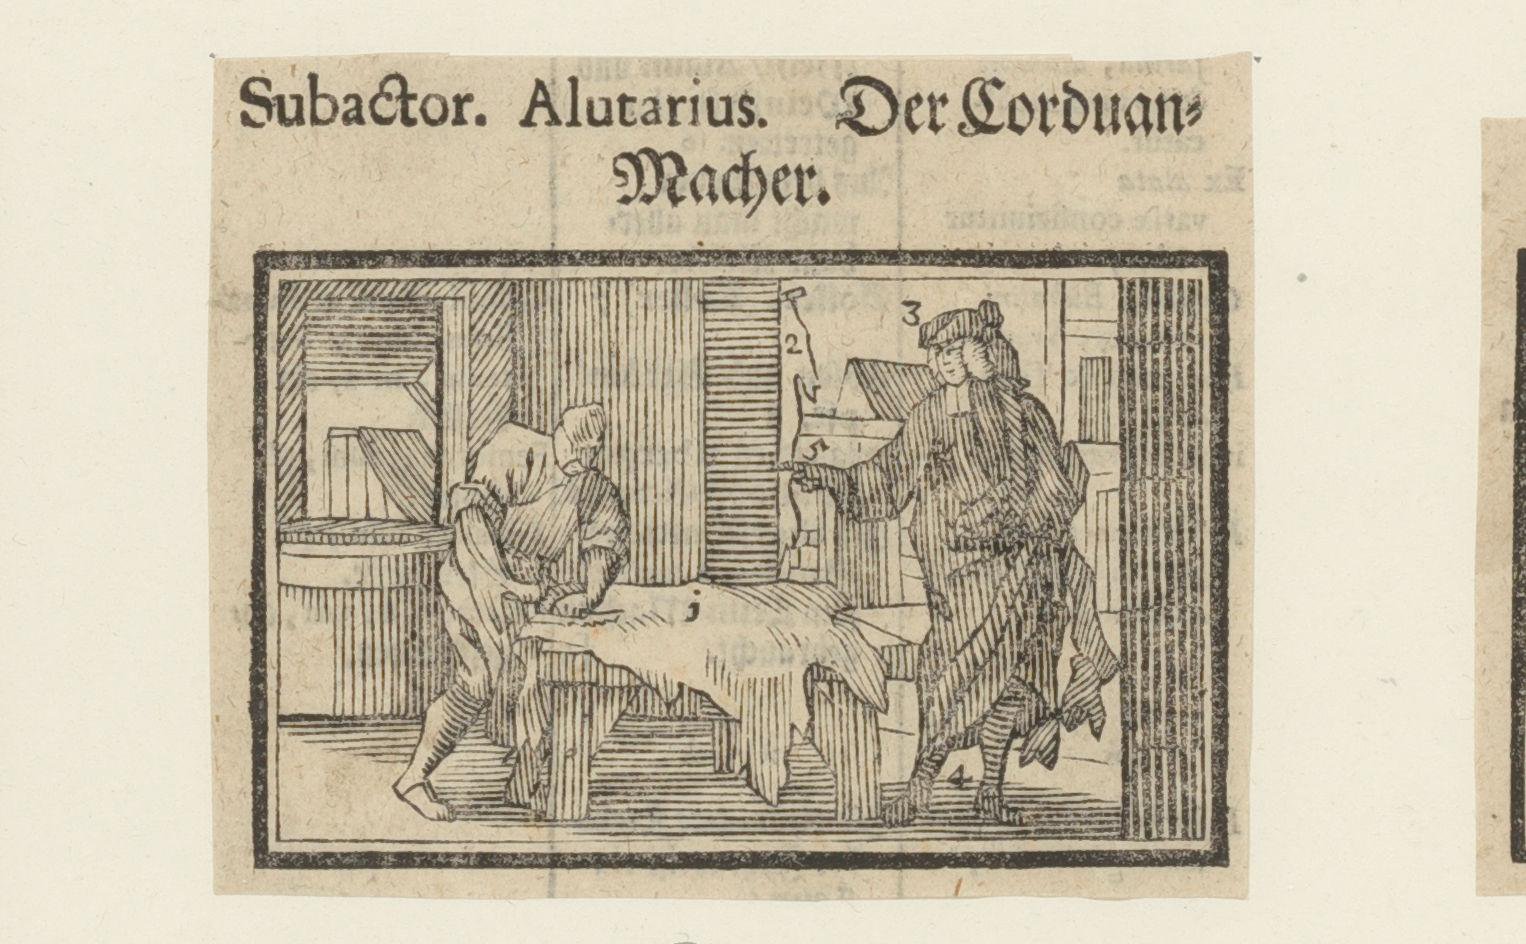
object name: print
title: Subactoor. Alutarius. Der Corduan-macher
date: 1719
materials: paper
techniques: letterpress printing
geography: nuremberg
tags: tanner, leather industry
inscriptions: stamp, collector's mark: Lugt 1641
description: De corduaanmaker bewerkt aan een tafel een stuk leer van geiten- of bokkenvellen. Dit wordt, volgens de beschrijving, gebruikt voor de bekleding van boeken en stoelen en voor zwarte schoenen en handschoenen, gedragen in de rouwtijd, zoals de man rechts toont. Onderwerpsrubrieken binnen de Atlas Zeden en Gewoonten: Handel, Nijverheid en Verkeer, Beroep en bedrijf, Complete suites.